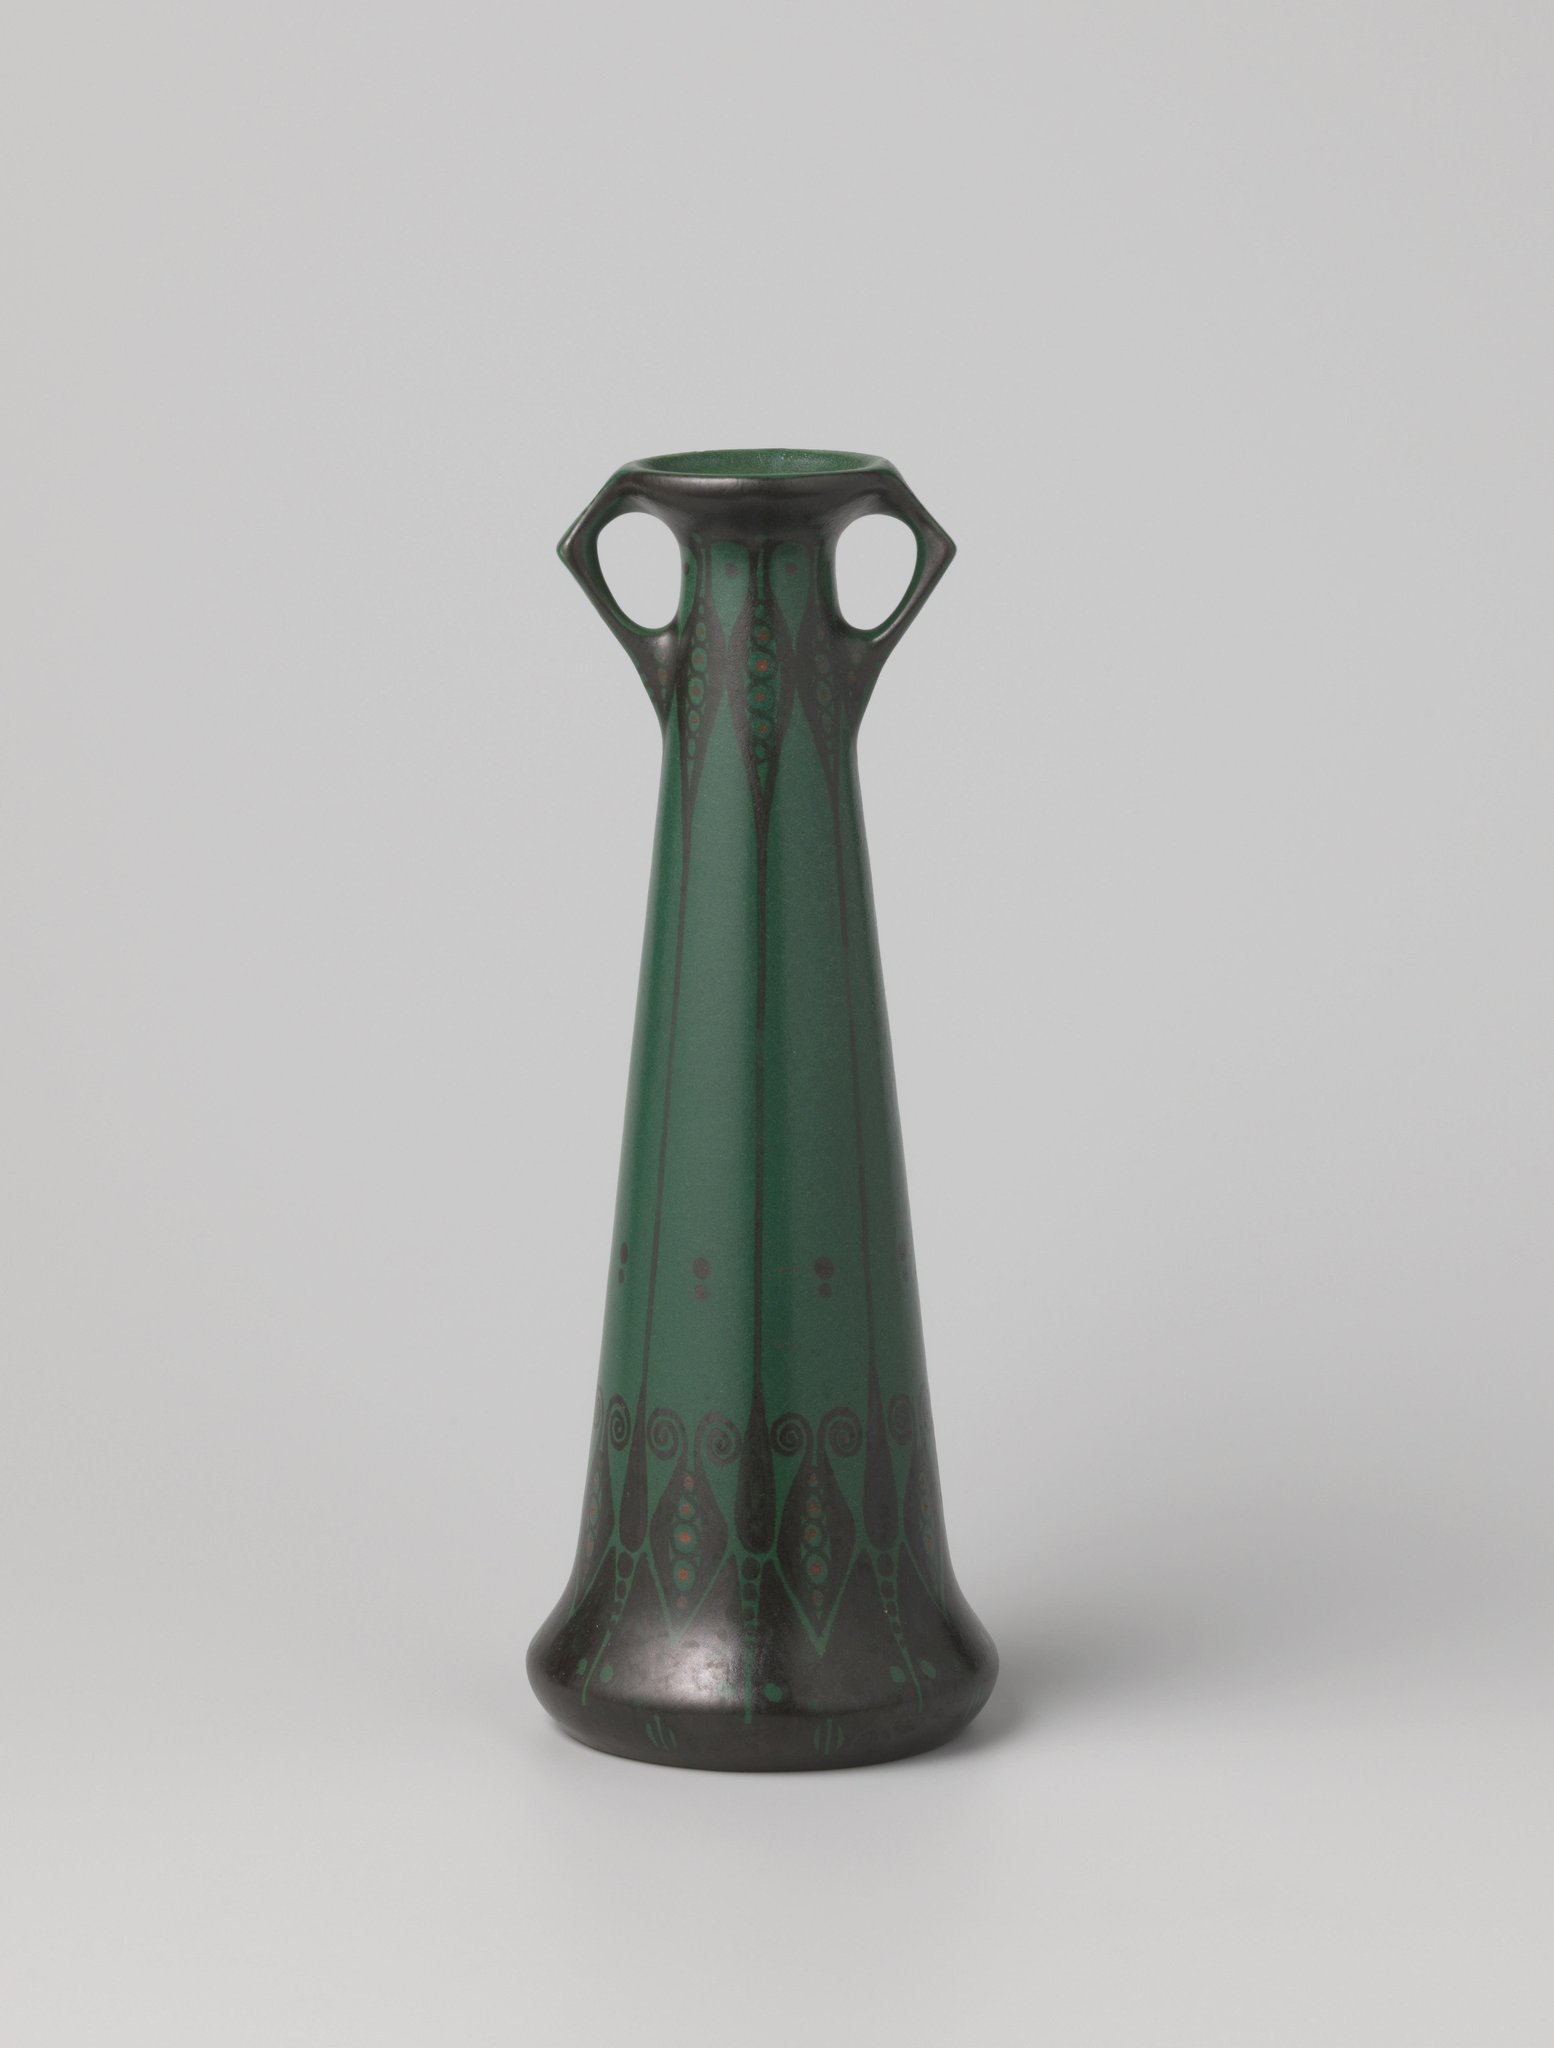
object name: vase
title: Vaas met abstract ornament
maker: bert nienhuis (i)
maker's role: designer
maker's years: 1873-1960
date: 1905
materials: earthenware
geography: amsterdam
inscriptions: mark: ‘cirkelvormig fabrieksmerk; letter V in zwart’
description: Vase. Earthenware. Amsterdam, c. 1905, made by Plateelbakkerij De Distel, designed by Lambertus Nienhuis, factory under the direction of J.M. Lob.